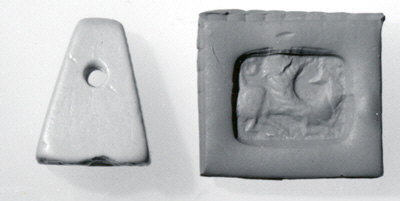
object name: stamp seal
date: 1000-1 BCE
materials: limestone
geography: central asia